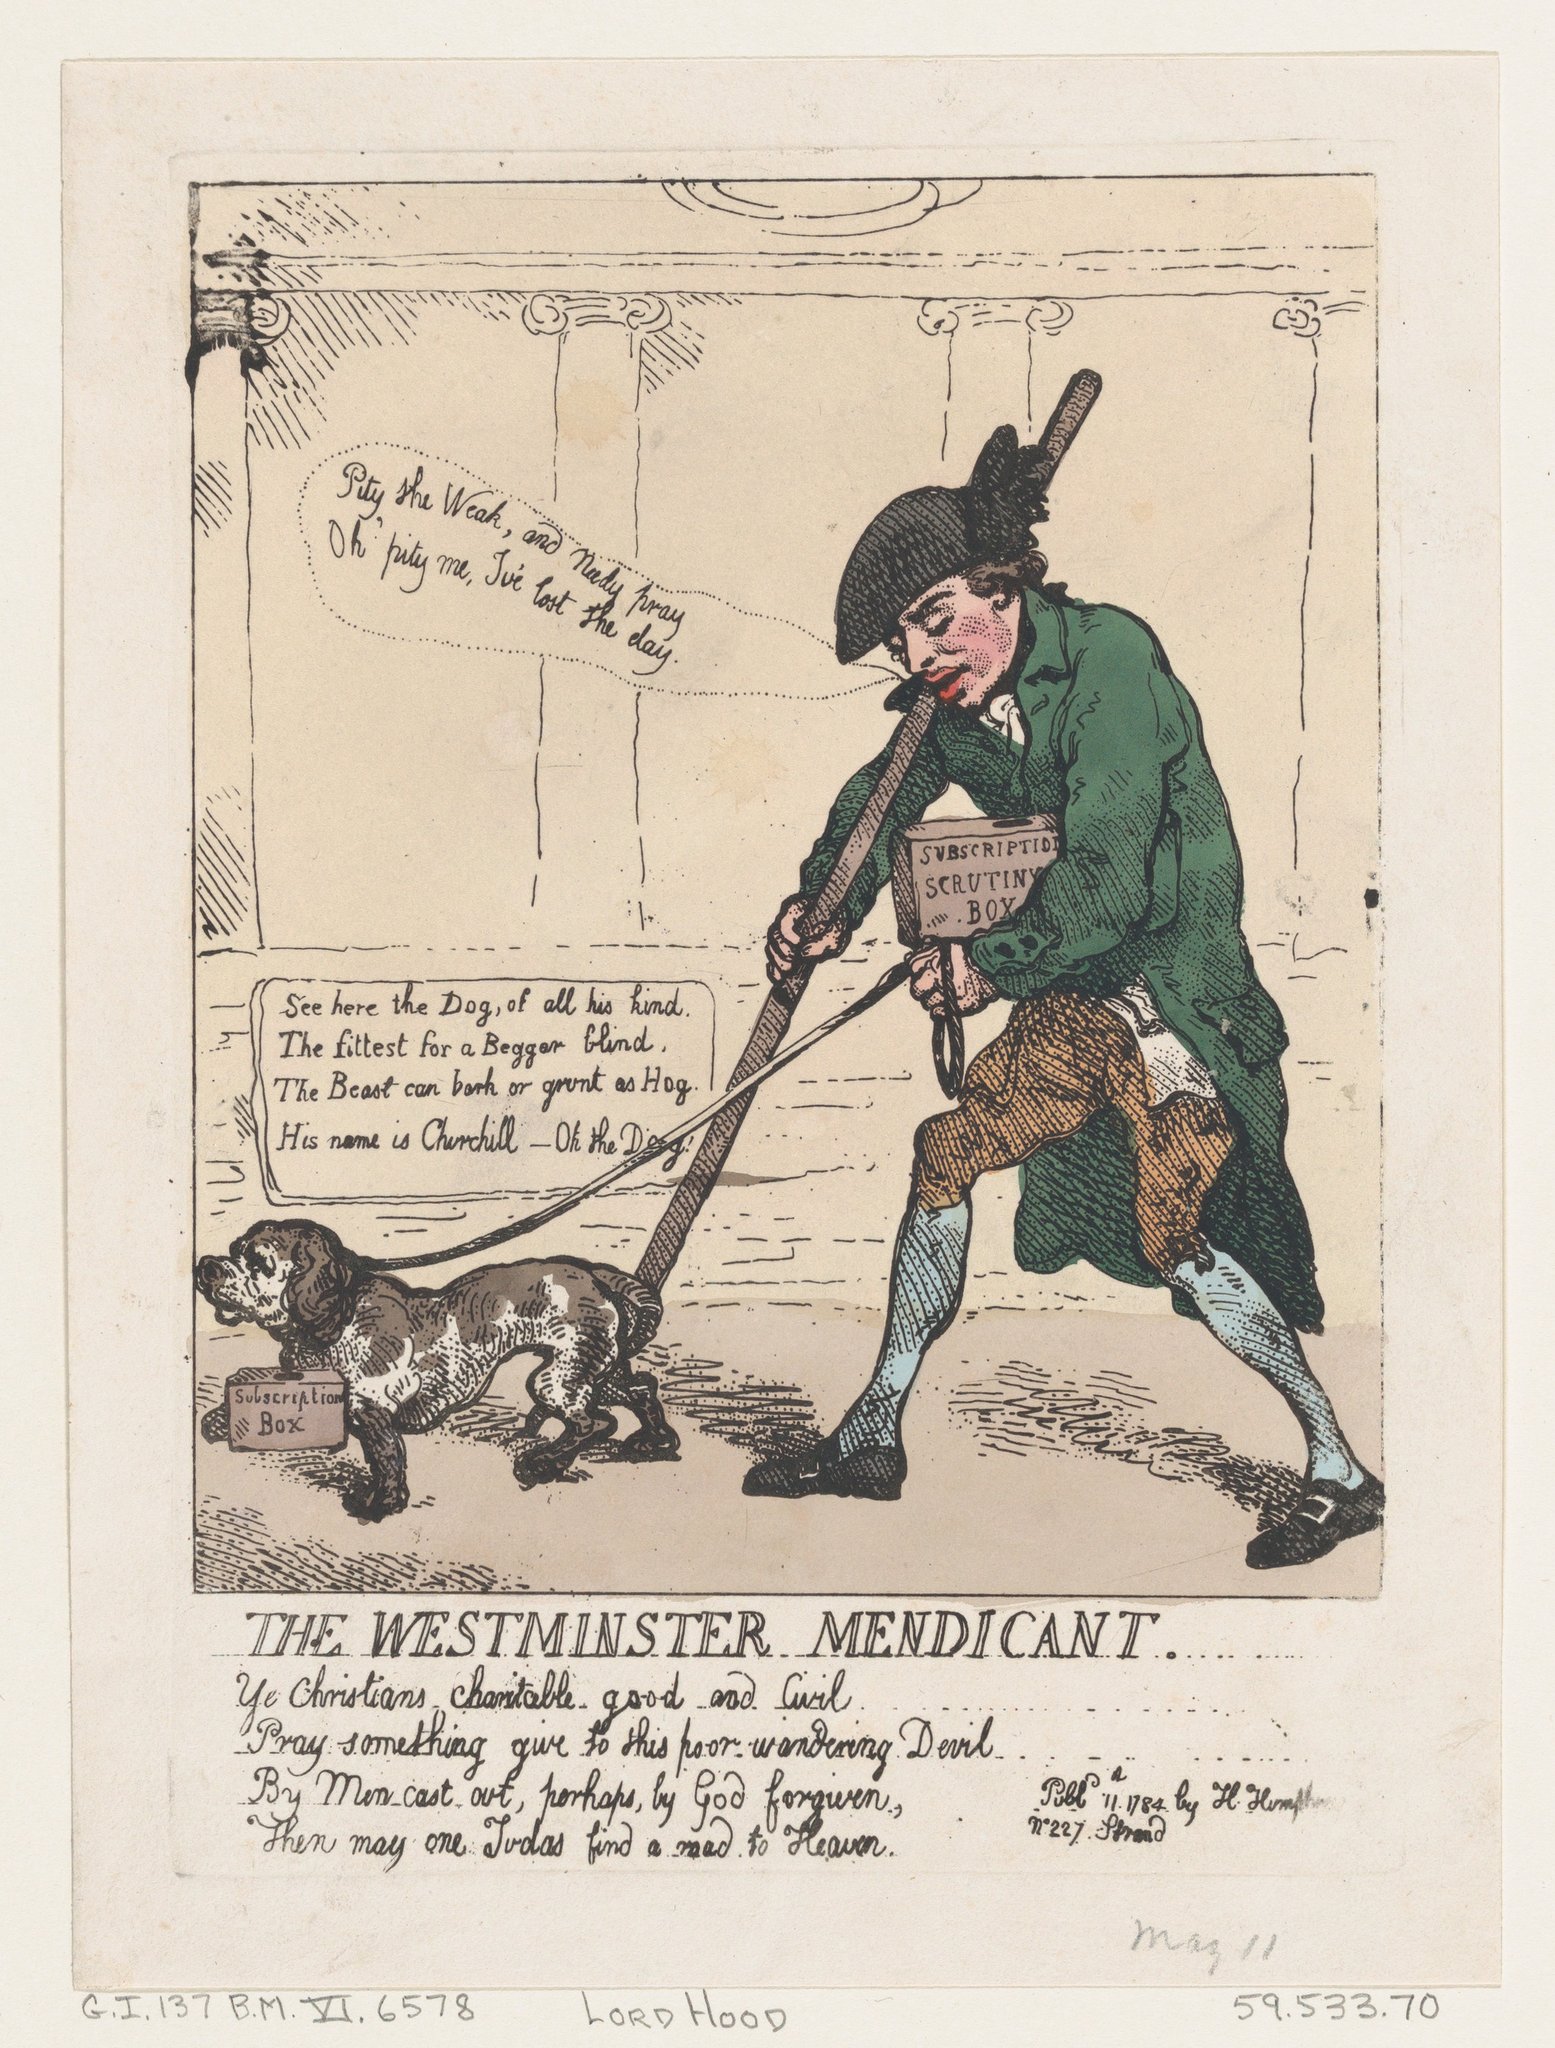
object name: print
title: The Westminster Mendicant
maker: thomas rowlandson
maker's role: artist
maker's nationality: british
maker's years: 1757-1827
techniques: etching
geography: london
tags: men,dogs